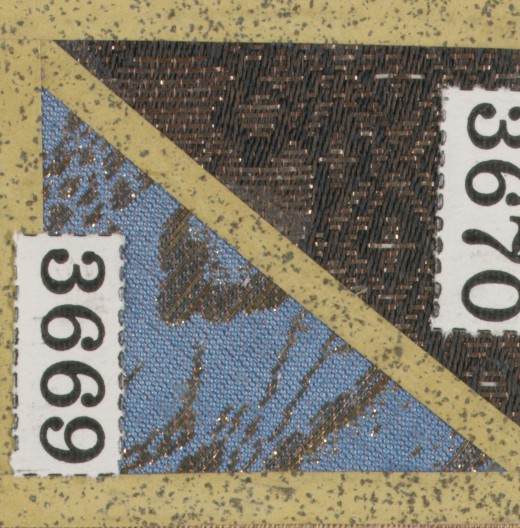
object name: sample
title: Textile Sample from Sample Book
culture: japanese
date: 1801-1900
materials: silk